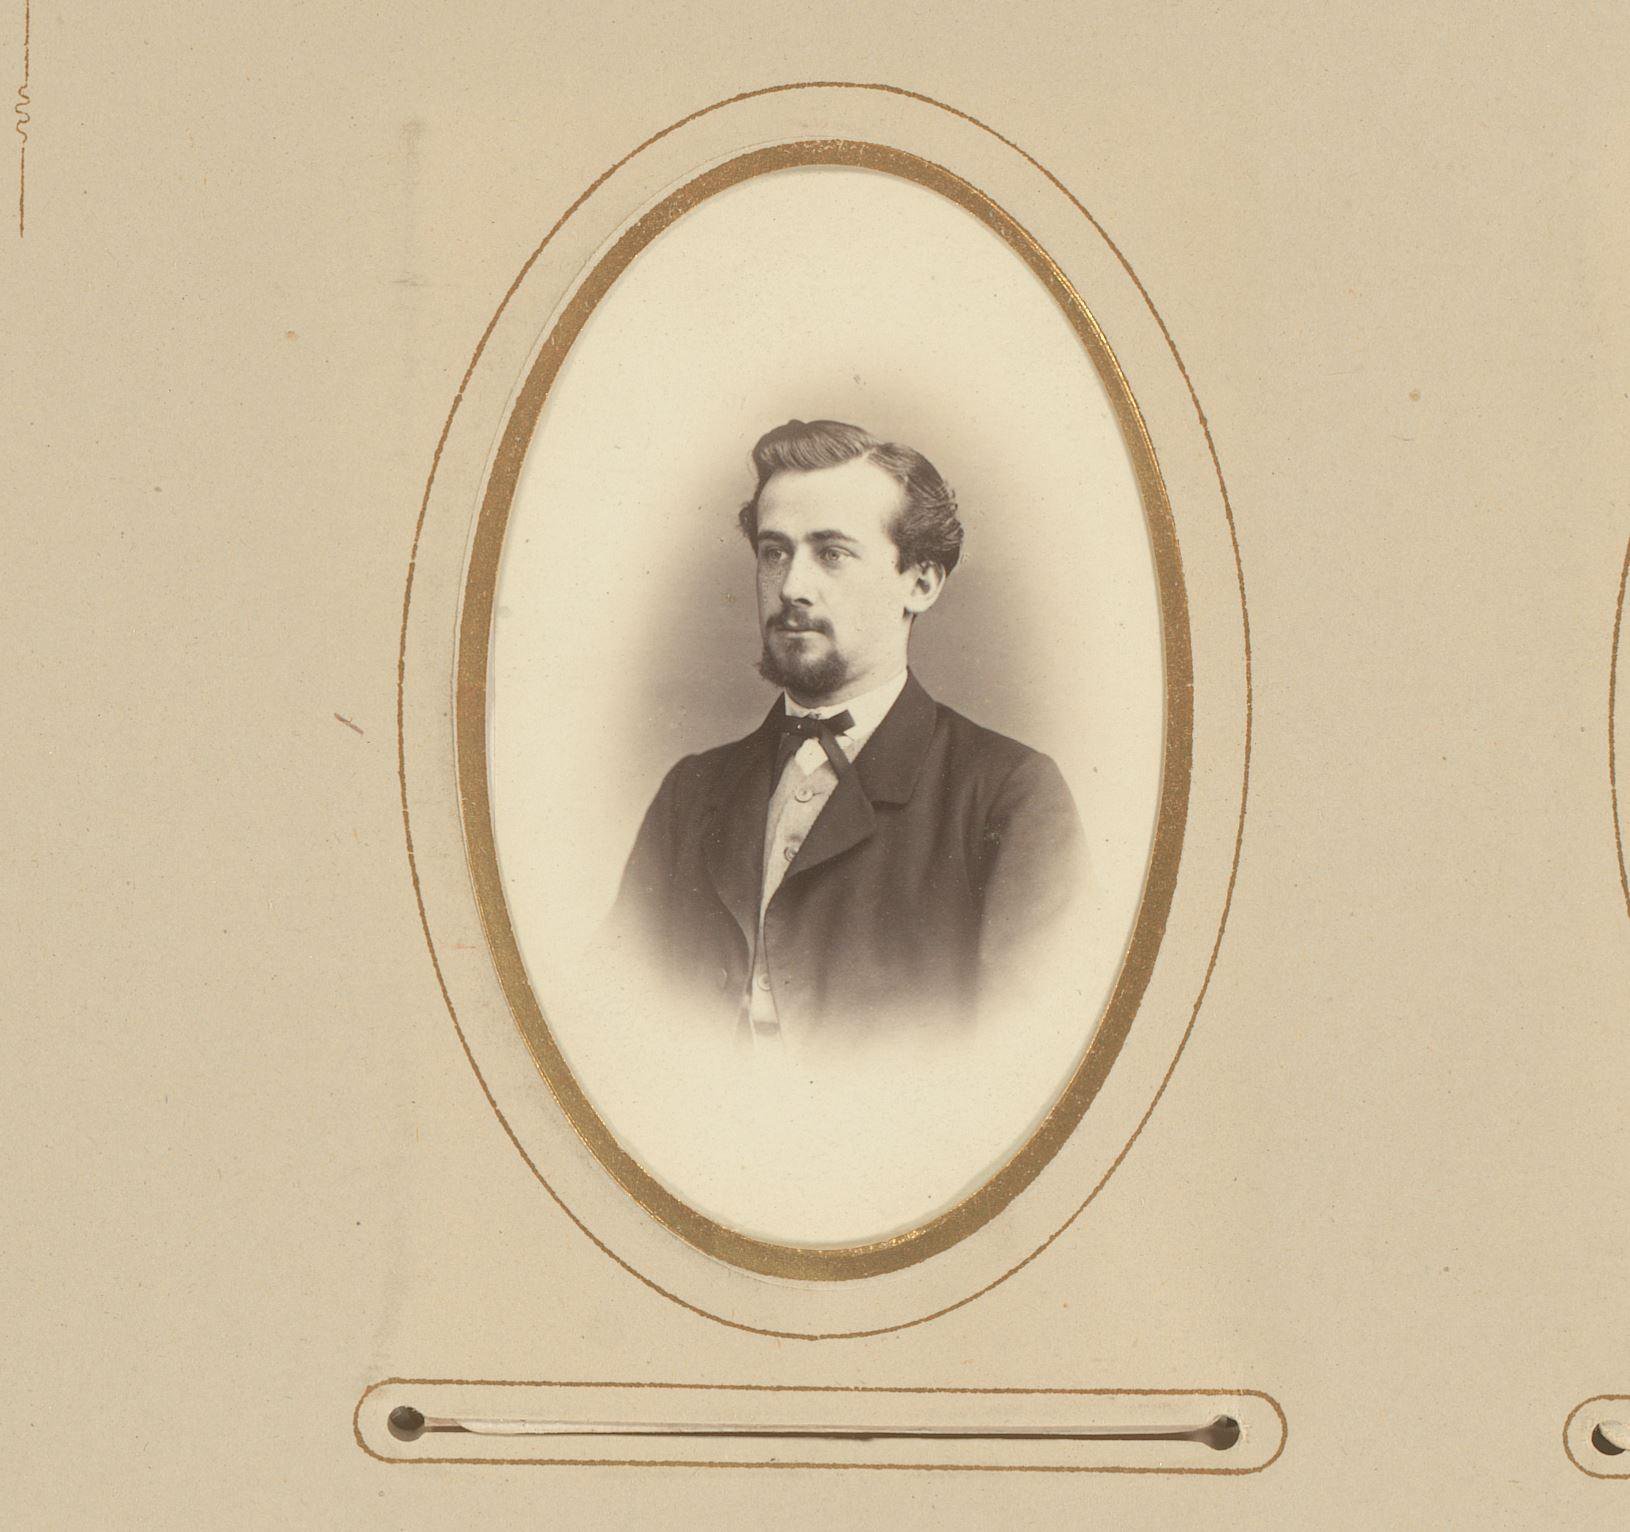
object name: carte de visite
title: Portret van een man met snor en baard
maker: f. springmeier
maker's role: fotograaf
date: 1850-1900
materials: cardboard, photographic support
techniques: albumen print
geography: elberfeld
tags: moustache, historical persons, beard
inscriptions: inscription: ‘F. Springmeier/ PHOTOGRAPH/ Elberfeld/ Herzogstrasse, No. 4.’